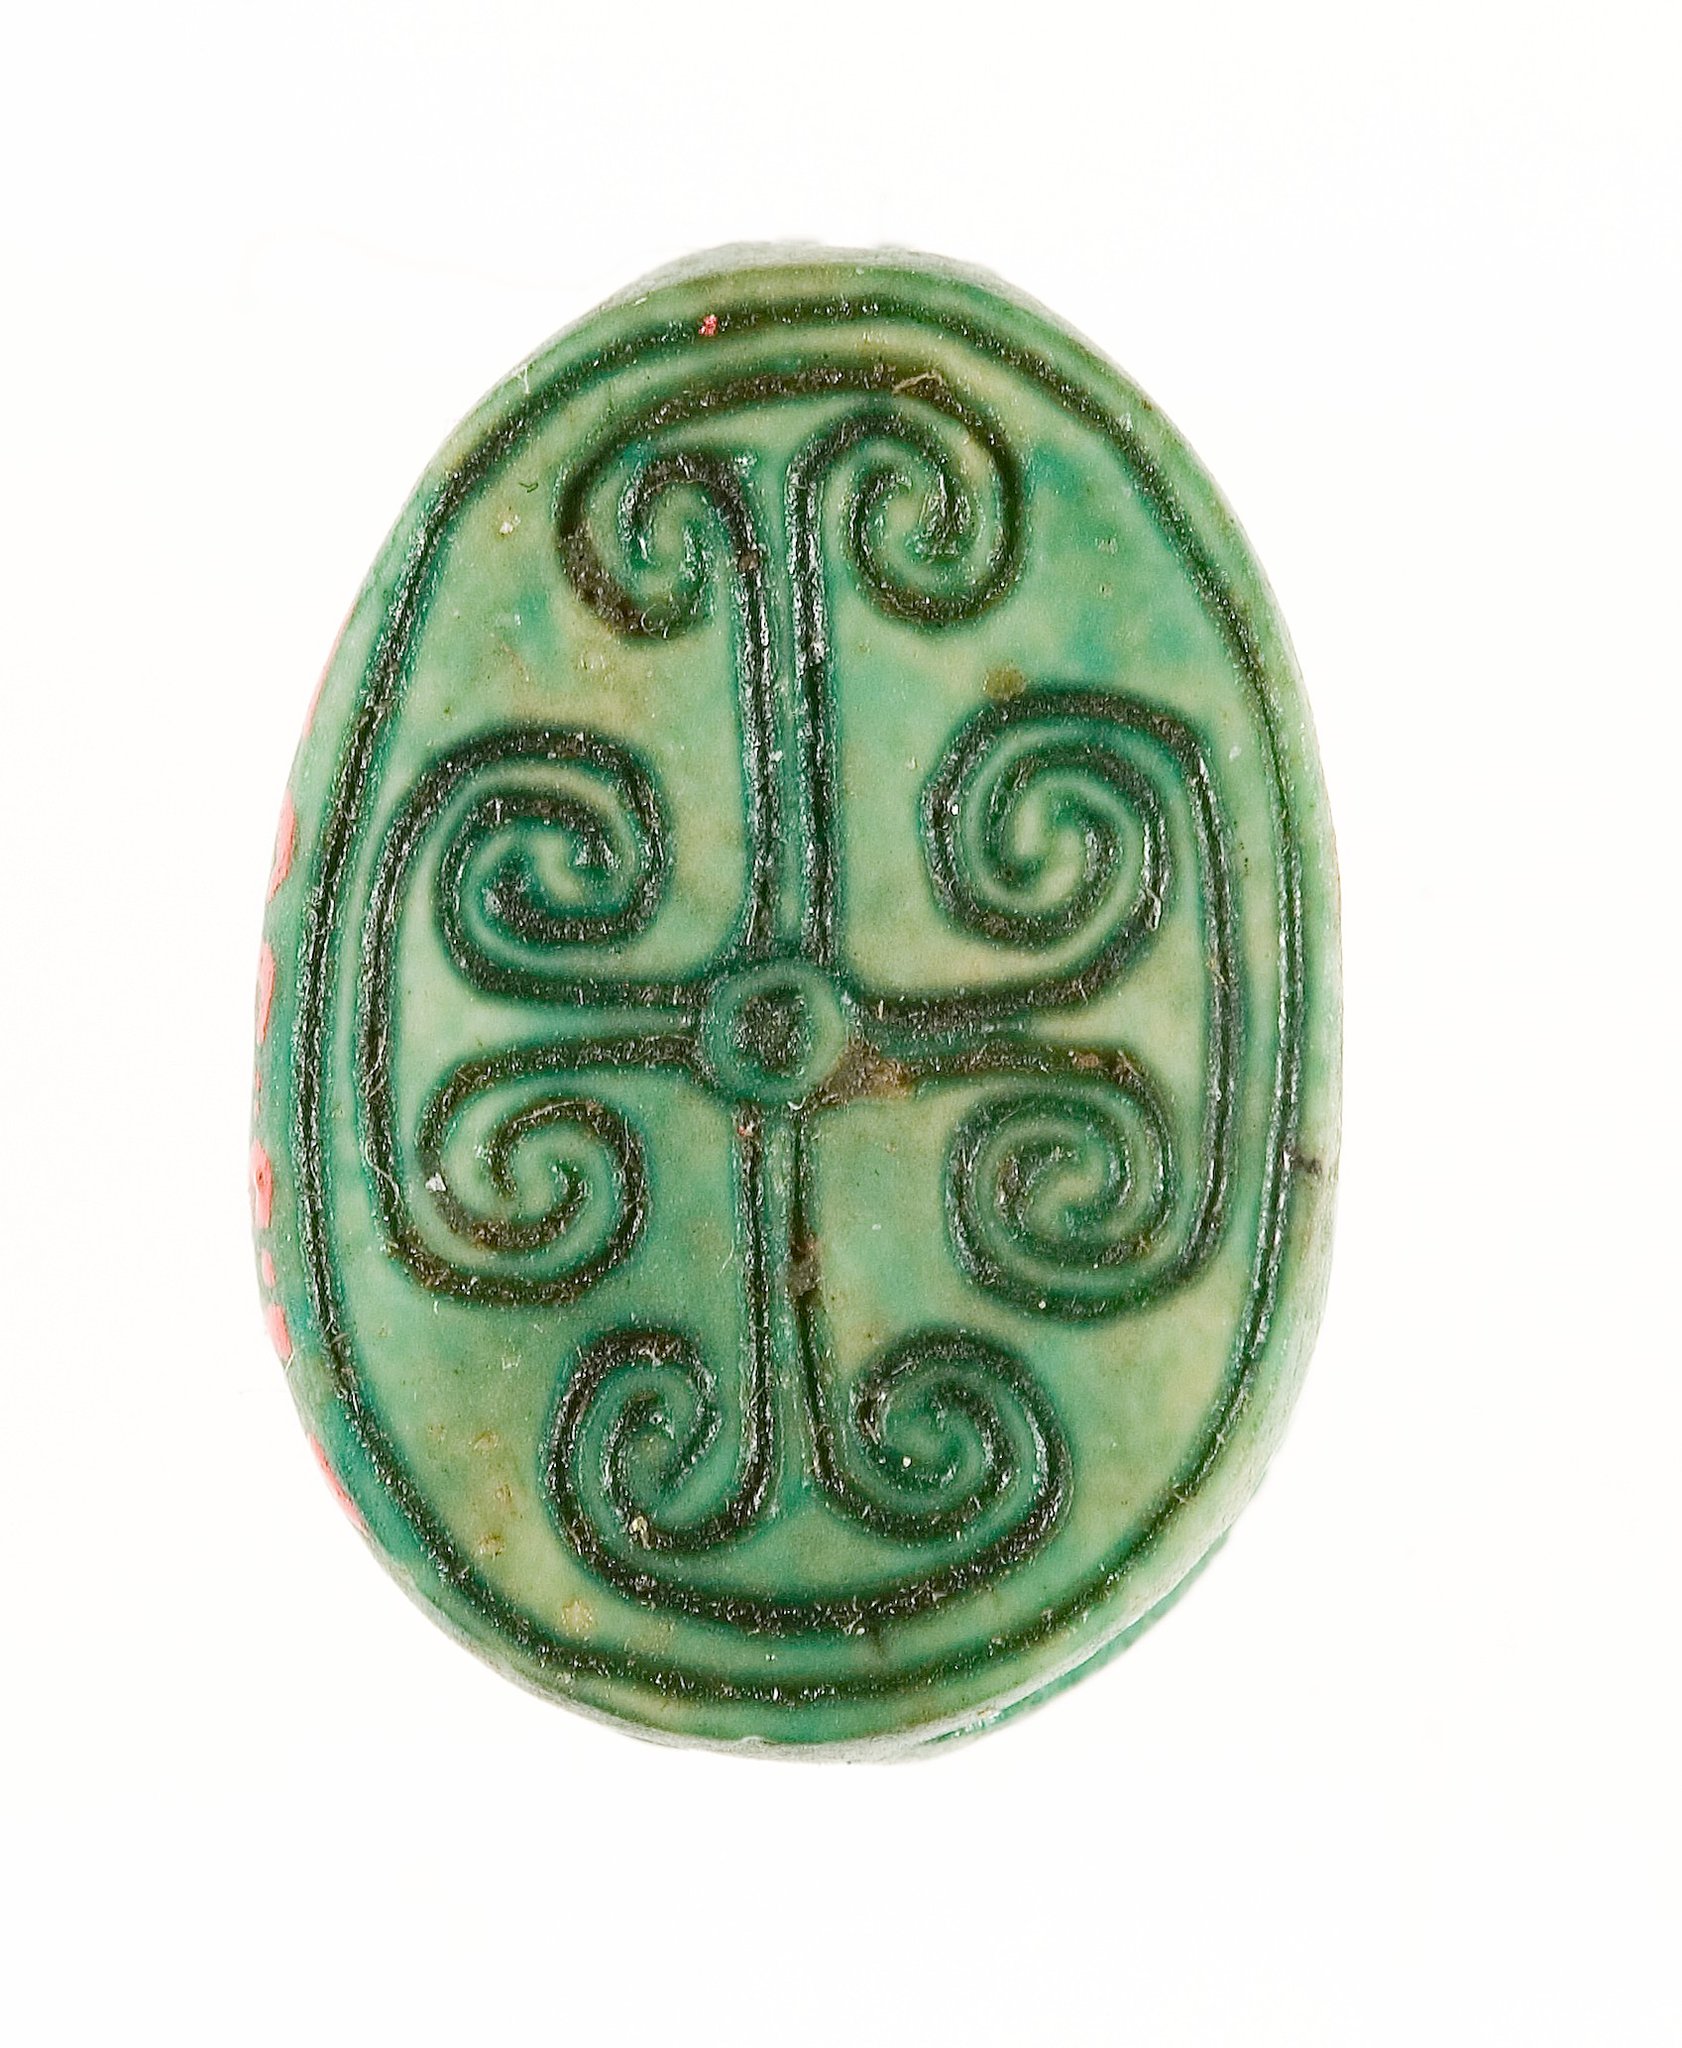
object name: scarab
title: Scarab Inscribed with a Geometric Pattern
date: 1479-1458 BCE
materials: stone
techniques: glazing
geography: egypt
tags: scarabs